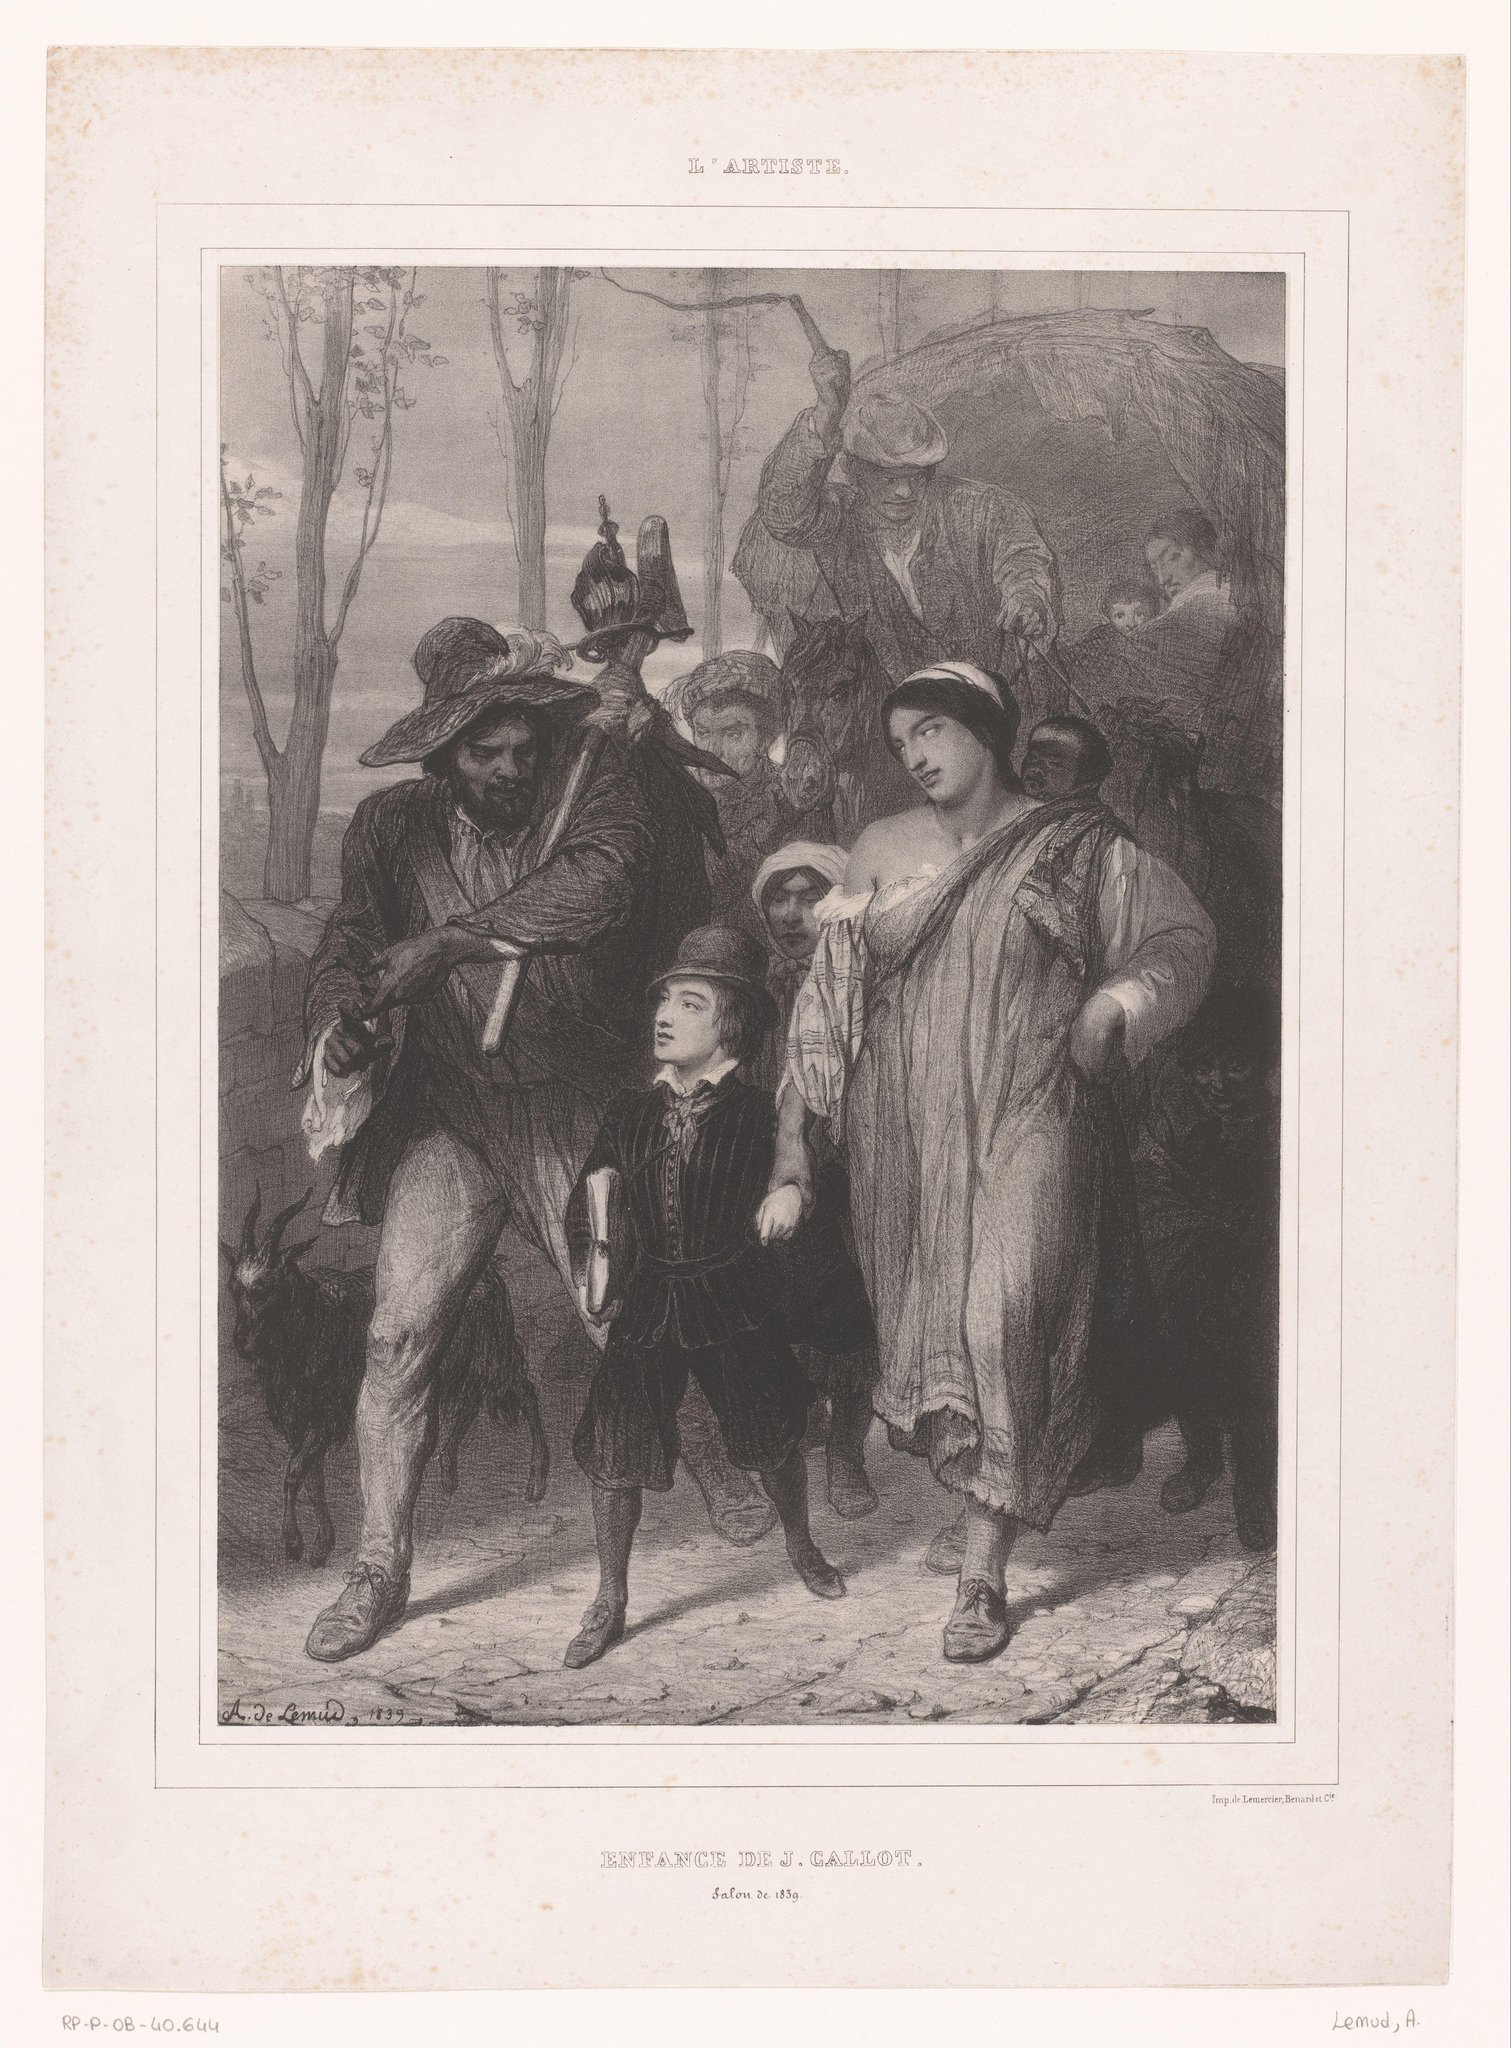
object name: print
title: Jacques Callot als kind op reis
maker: aimé de lemud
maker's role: print maker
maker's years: 1816-1887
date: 1839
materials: paper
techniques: lithography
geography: paris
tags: print maker, draughtsman, jacques callot, boy (child between toddler and youth), historical persons, 'en route', traveller under way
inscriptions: collector's mark: Lugt 2228a